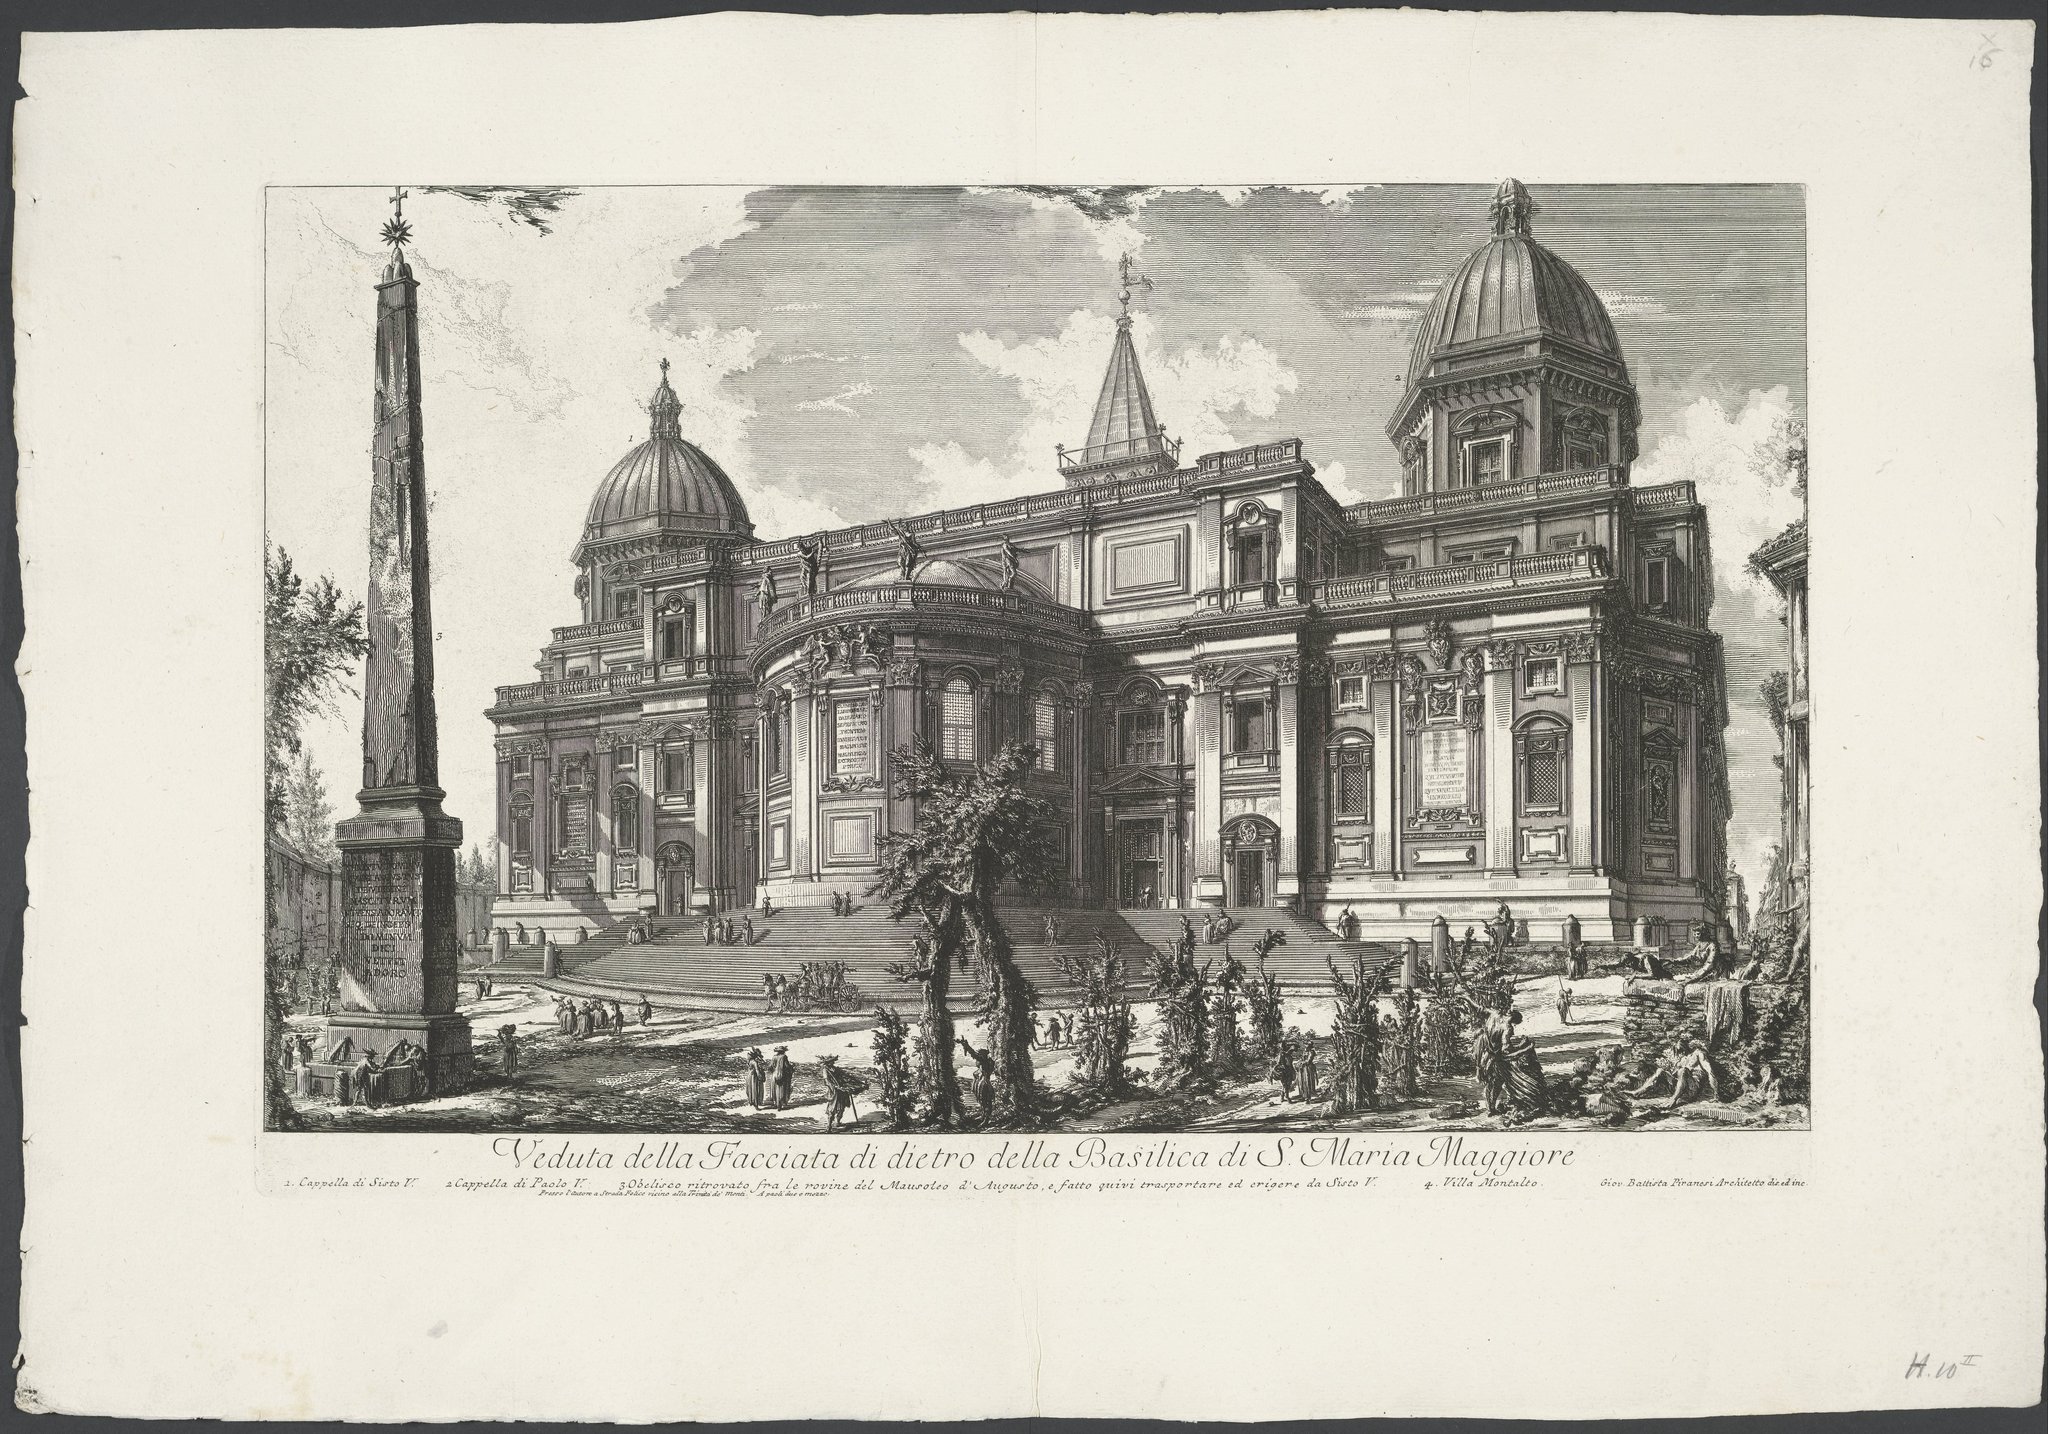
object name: print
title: Vedute di Roma disegnate ed incise da Giambattista Piranesi architetto Ve(nez)iano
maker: giovanni battista piranesi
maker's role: designer, draughtsman, print maker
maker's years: 1720-1778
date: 1748-1778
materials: paper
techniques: etching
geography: rome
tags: obelisk, needle, church (exterior), roman catholic church, rome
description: Deze prent maakt deel uit van de serie 'Vedute di Roma'. Piranesi werkte aan deze 135 platen tellende serie tussen 1748 en zijn dood in 1778. Francesco Piranesi voegde later nog twee prenten toe aan de reeks van zijn vader.